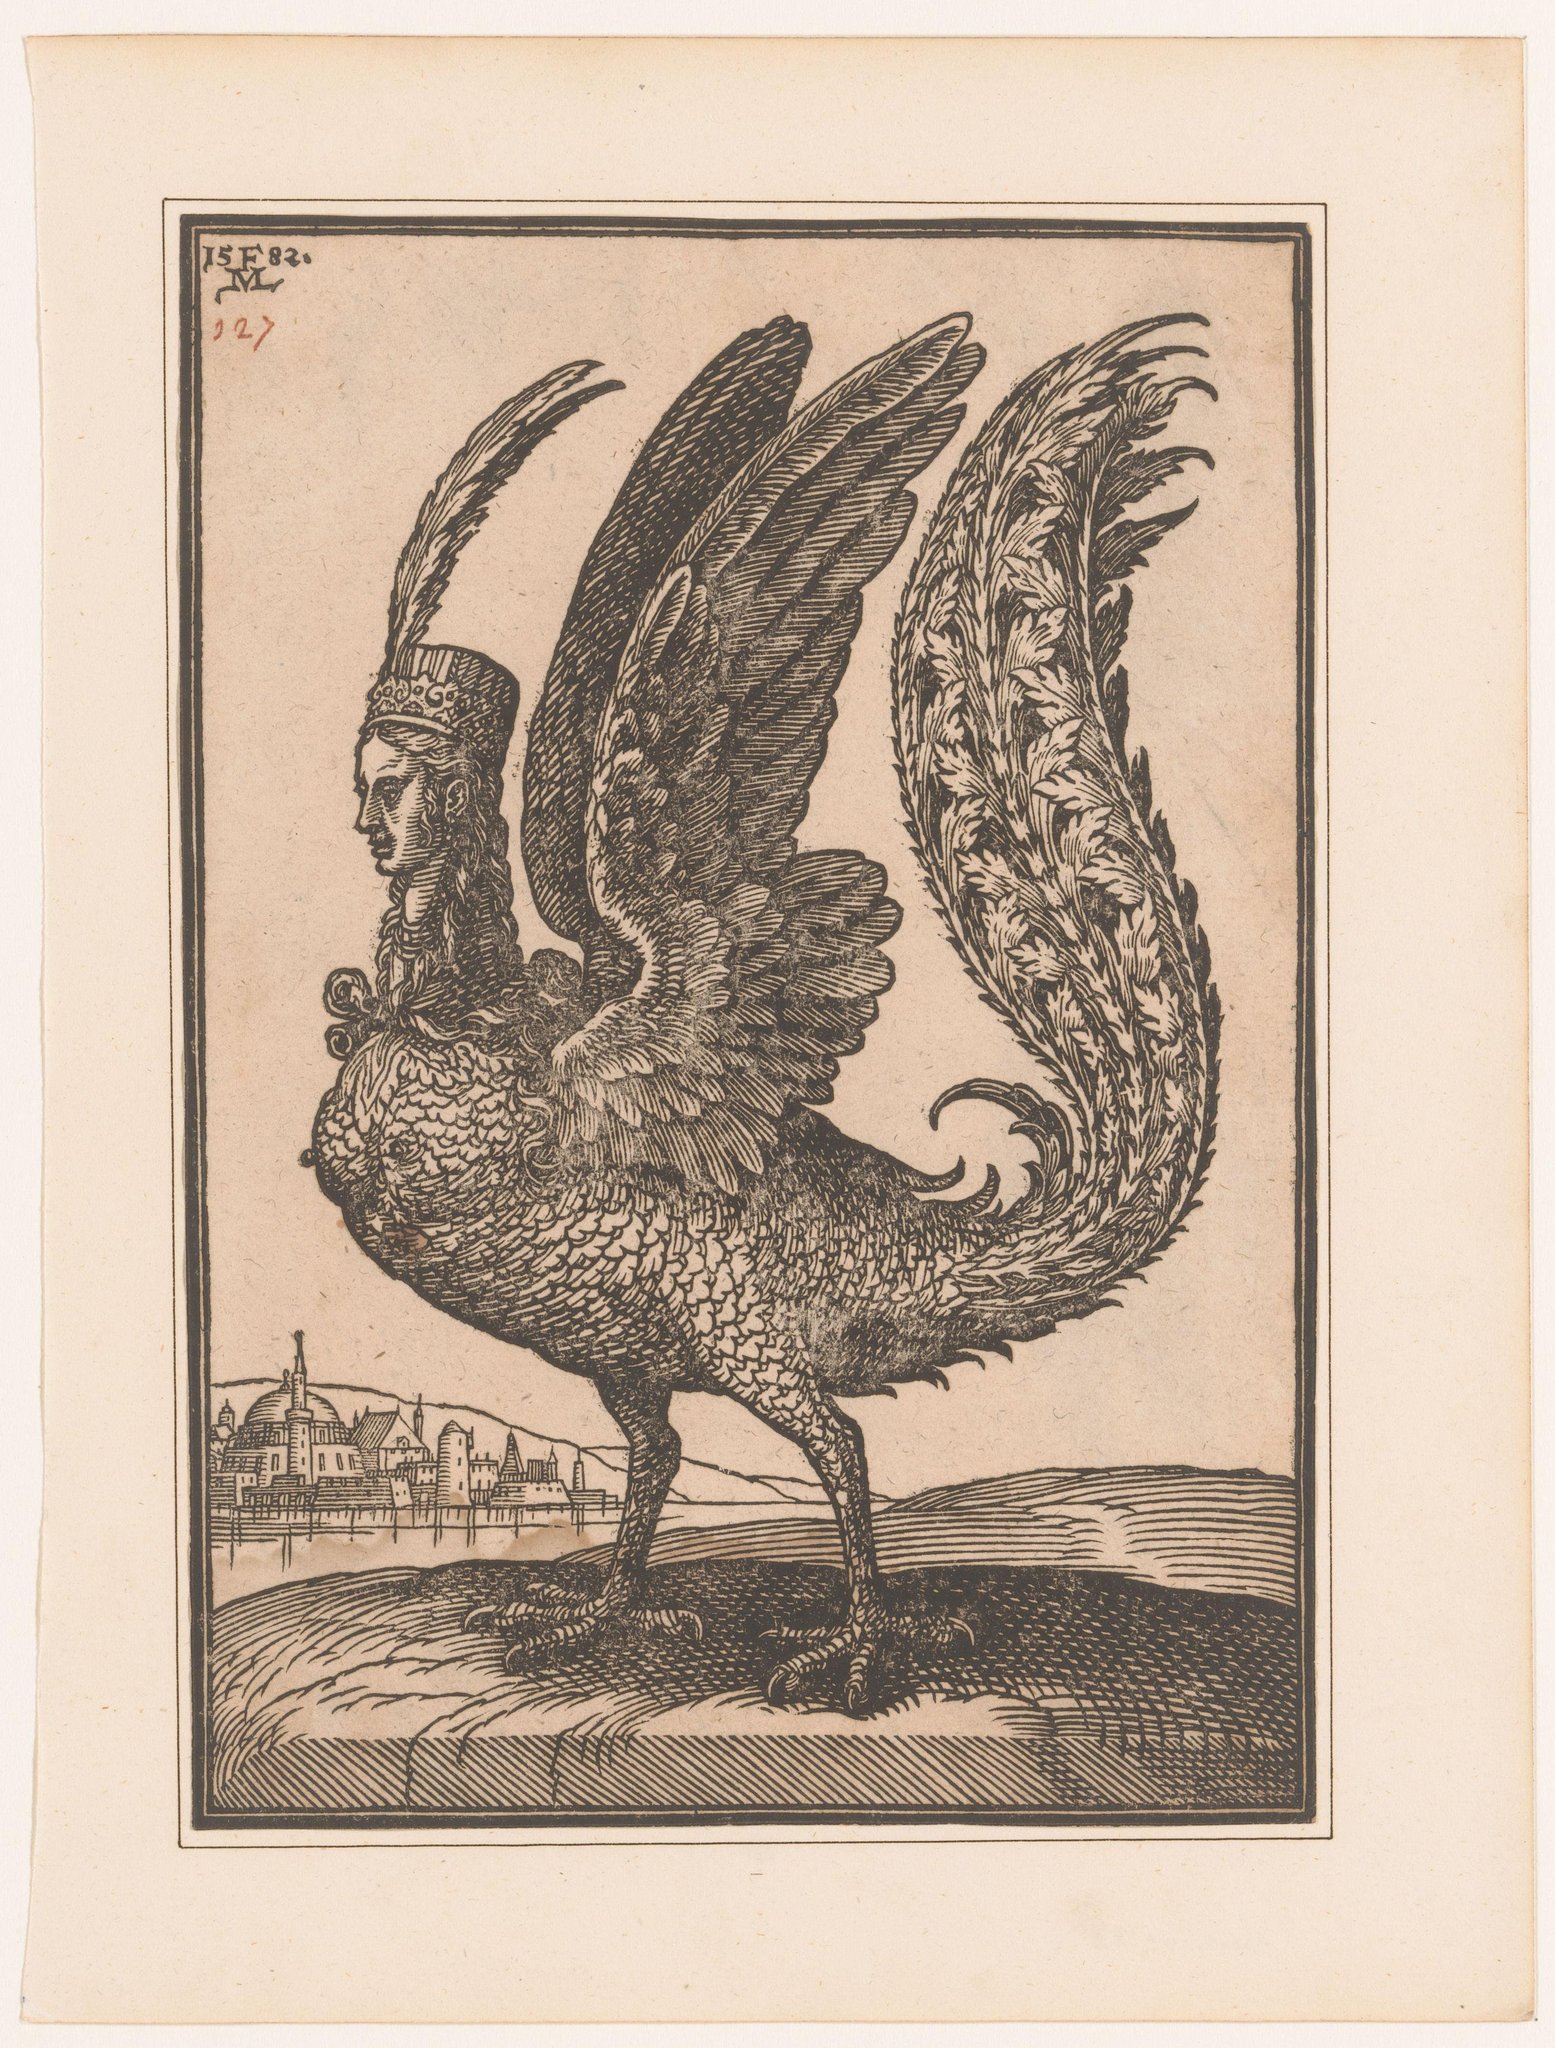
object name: book illustration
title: Harpij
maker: melchior lorck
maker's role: draughtsman, painter, print maker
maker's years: 1526-1588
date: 1582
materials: paper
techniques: woodcut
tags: harpy (fabulous bird); 'arpie' (ripa)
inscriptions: collector's mark: Lugt 2760, collector's mark: Lugt 2228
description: Uit de editie van 1626 of 1646. Melchior Lorck: Wolgerissene und Geschnittene Figuren, zu Ross und Fuss, sampt schönen Türckischen Gebäwden, und allerhand was in der Türckey zusehen.